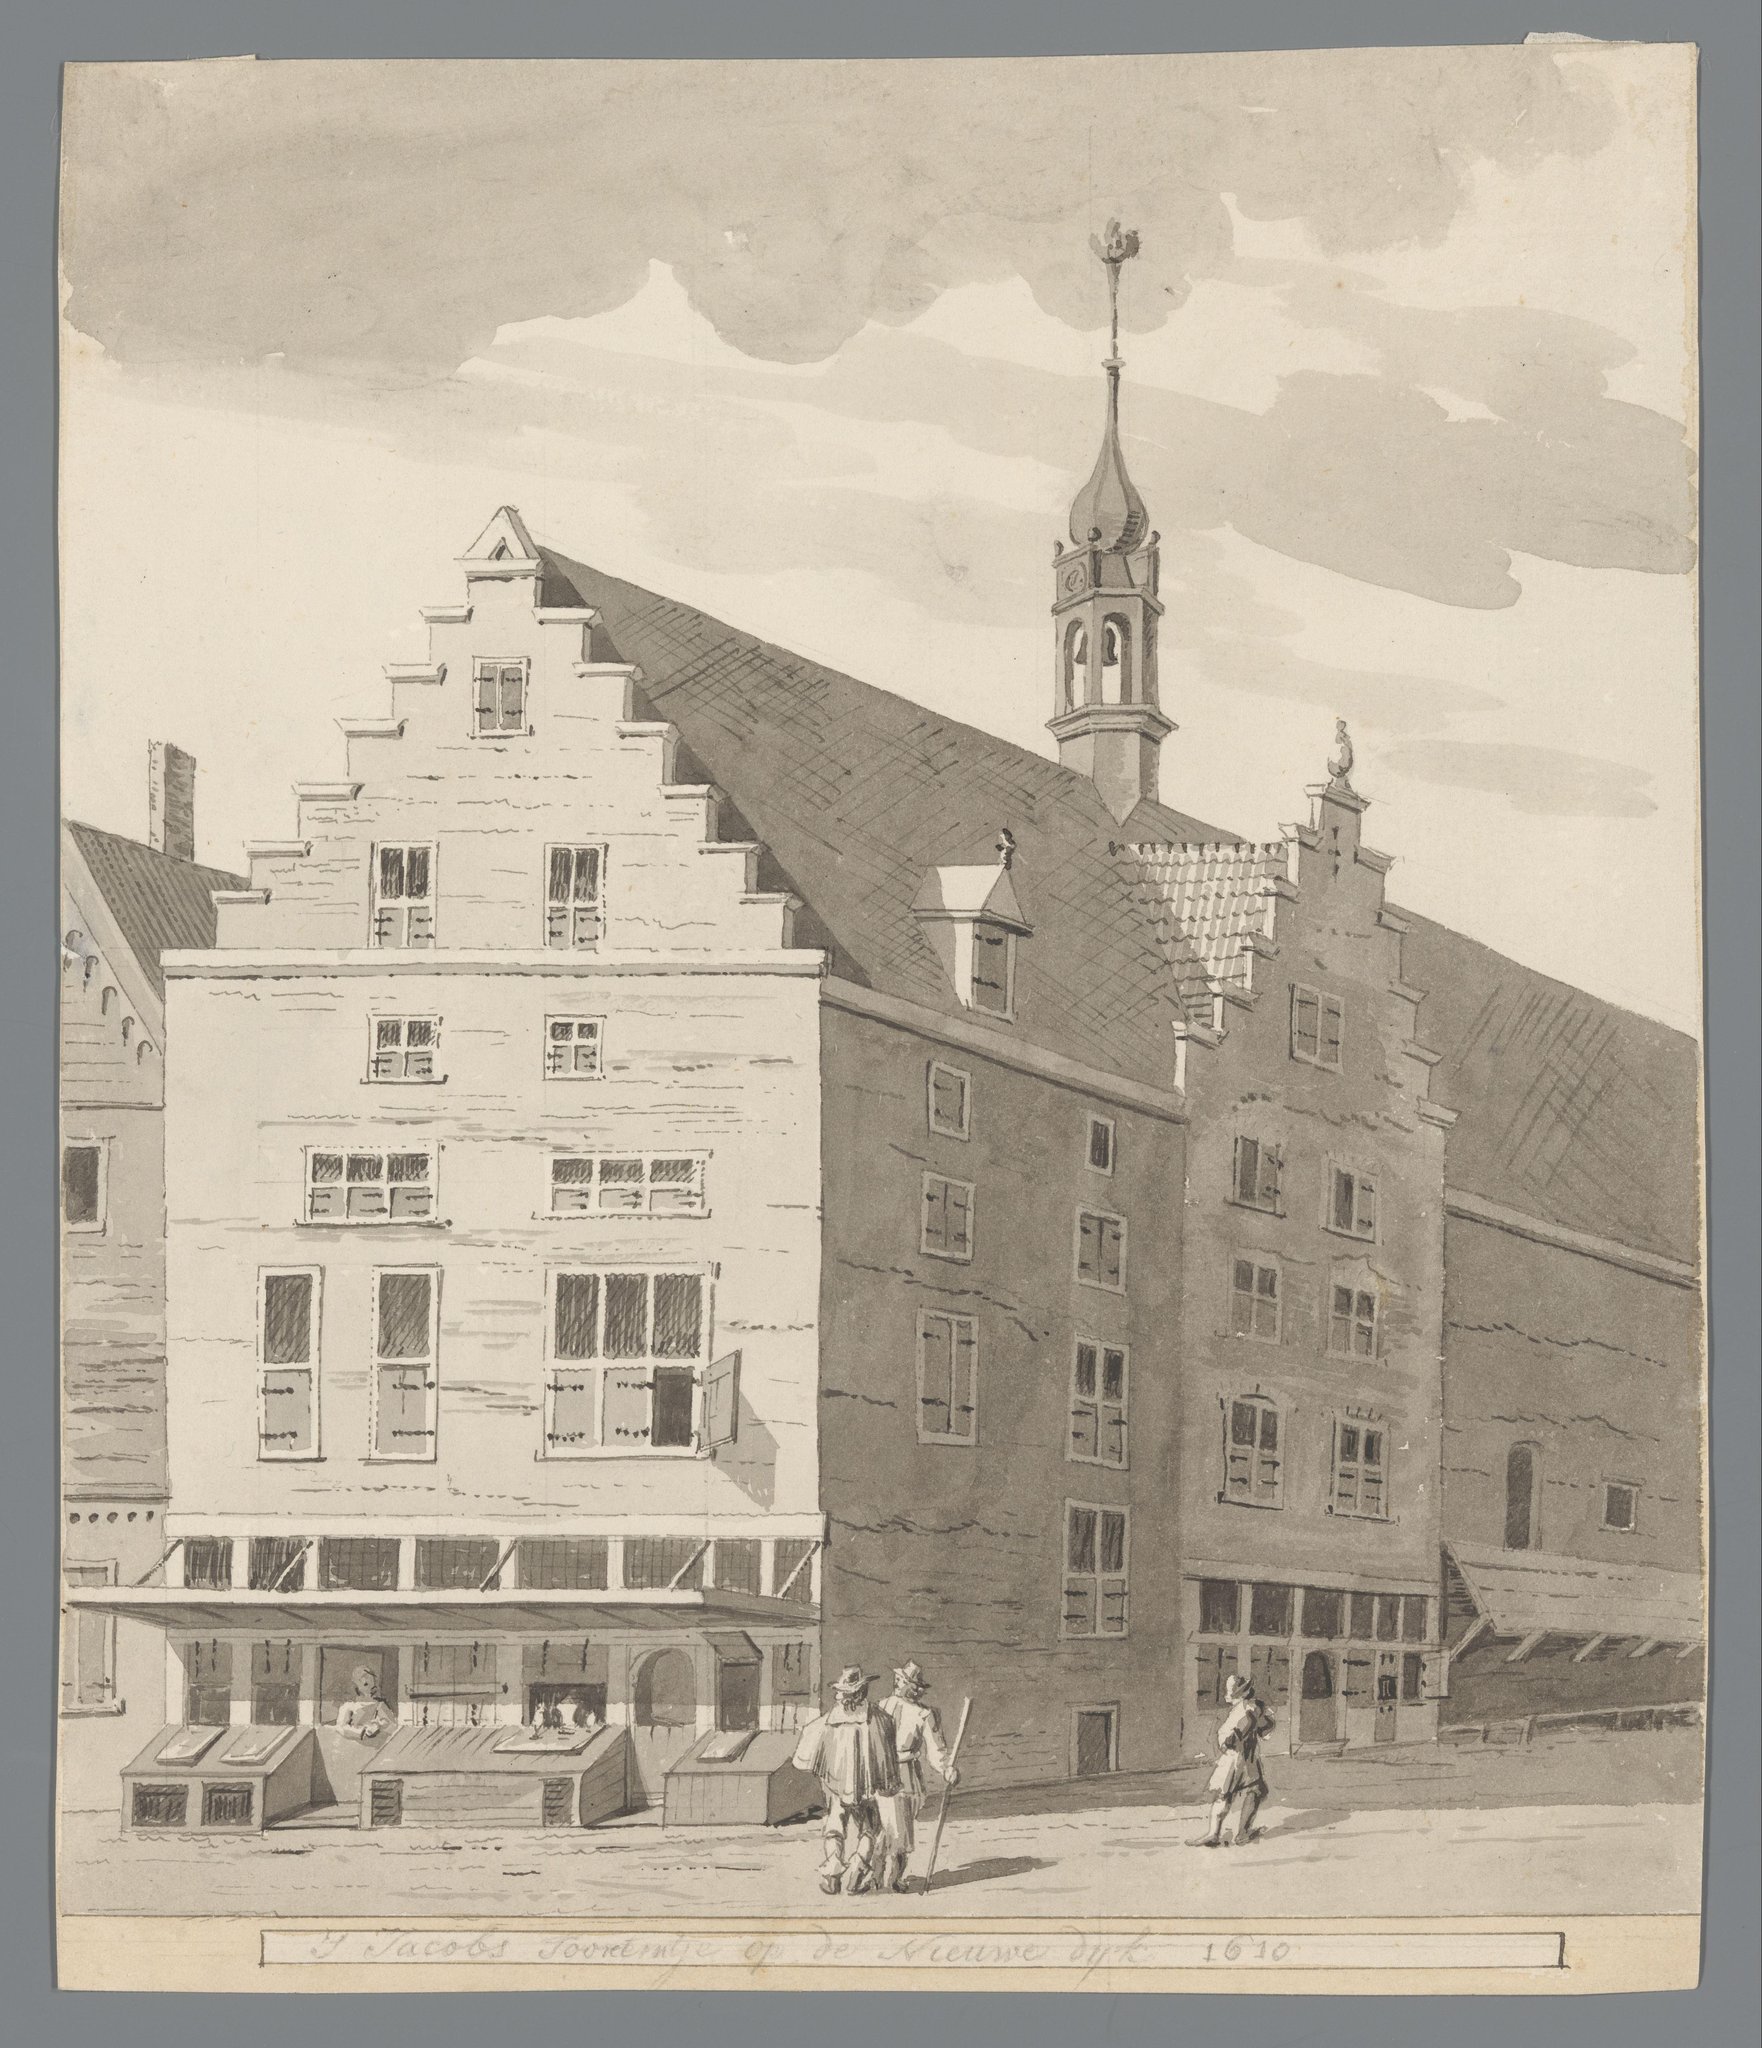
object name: drawing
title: Gezicht op de Sint-Jacobstoren te Amsterdam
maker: Anonymous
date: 1610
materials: ink, paper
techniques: brush, pen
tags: village street, amsterdam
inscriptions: collector's mark: Lugt 2228